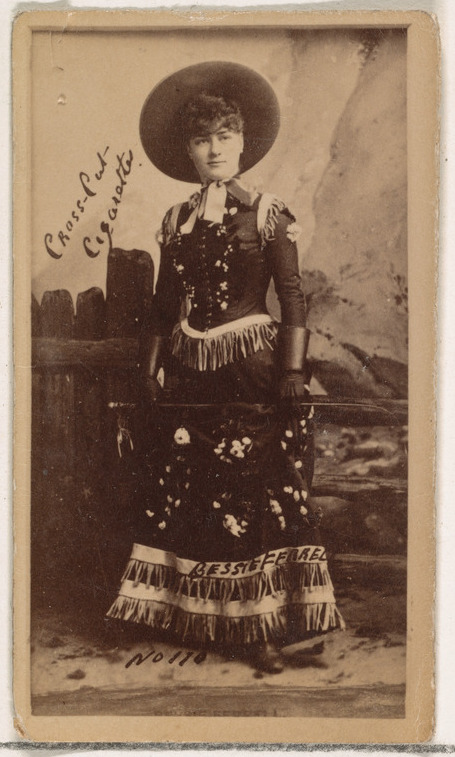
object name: print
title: Card Number 110, Bessie Ferrel, from the Actors and Actresses series (N145-1) issued by Duke Sons & Co. to promote Cross Cut Cigarettes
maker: w. duke, sons & co.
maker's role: publisher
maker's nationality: american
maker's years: 1870-1920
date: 1880-1889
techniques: albumen silver print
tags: portraits,women,actresses